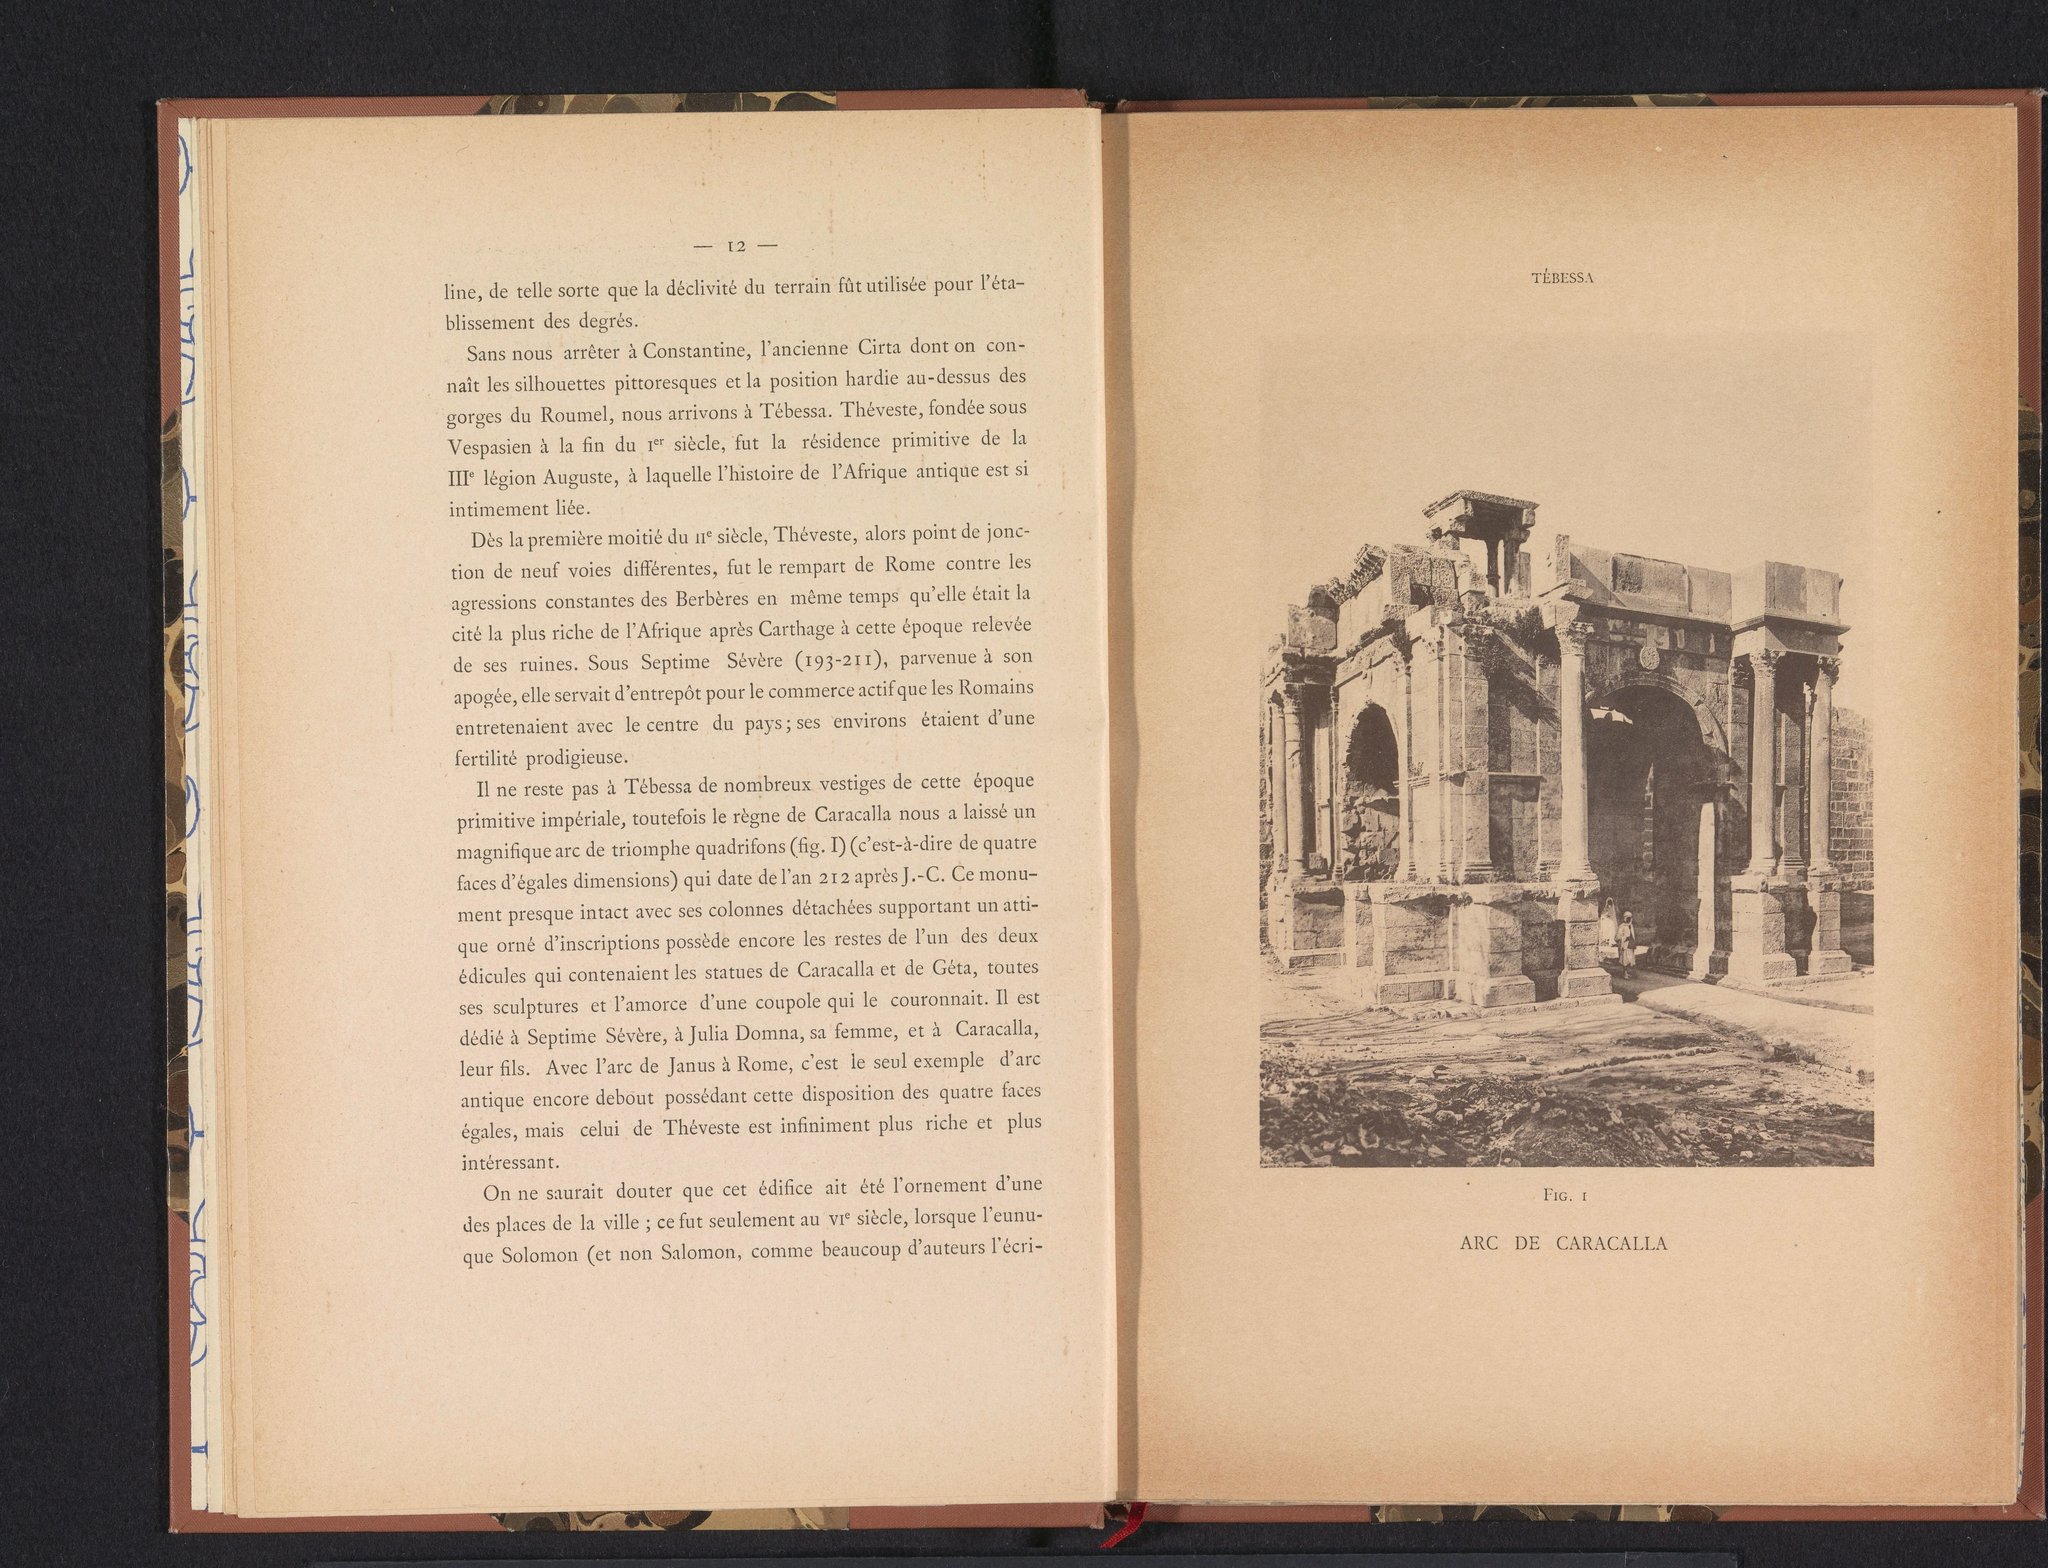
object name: page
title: Gezicht op de Boog van Caracalla in Tébessa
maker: Anonymous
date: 1884-1894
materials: paper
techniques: photograph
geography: france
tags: triumphal arch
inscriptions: number: ‘Fig. I’